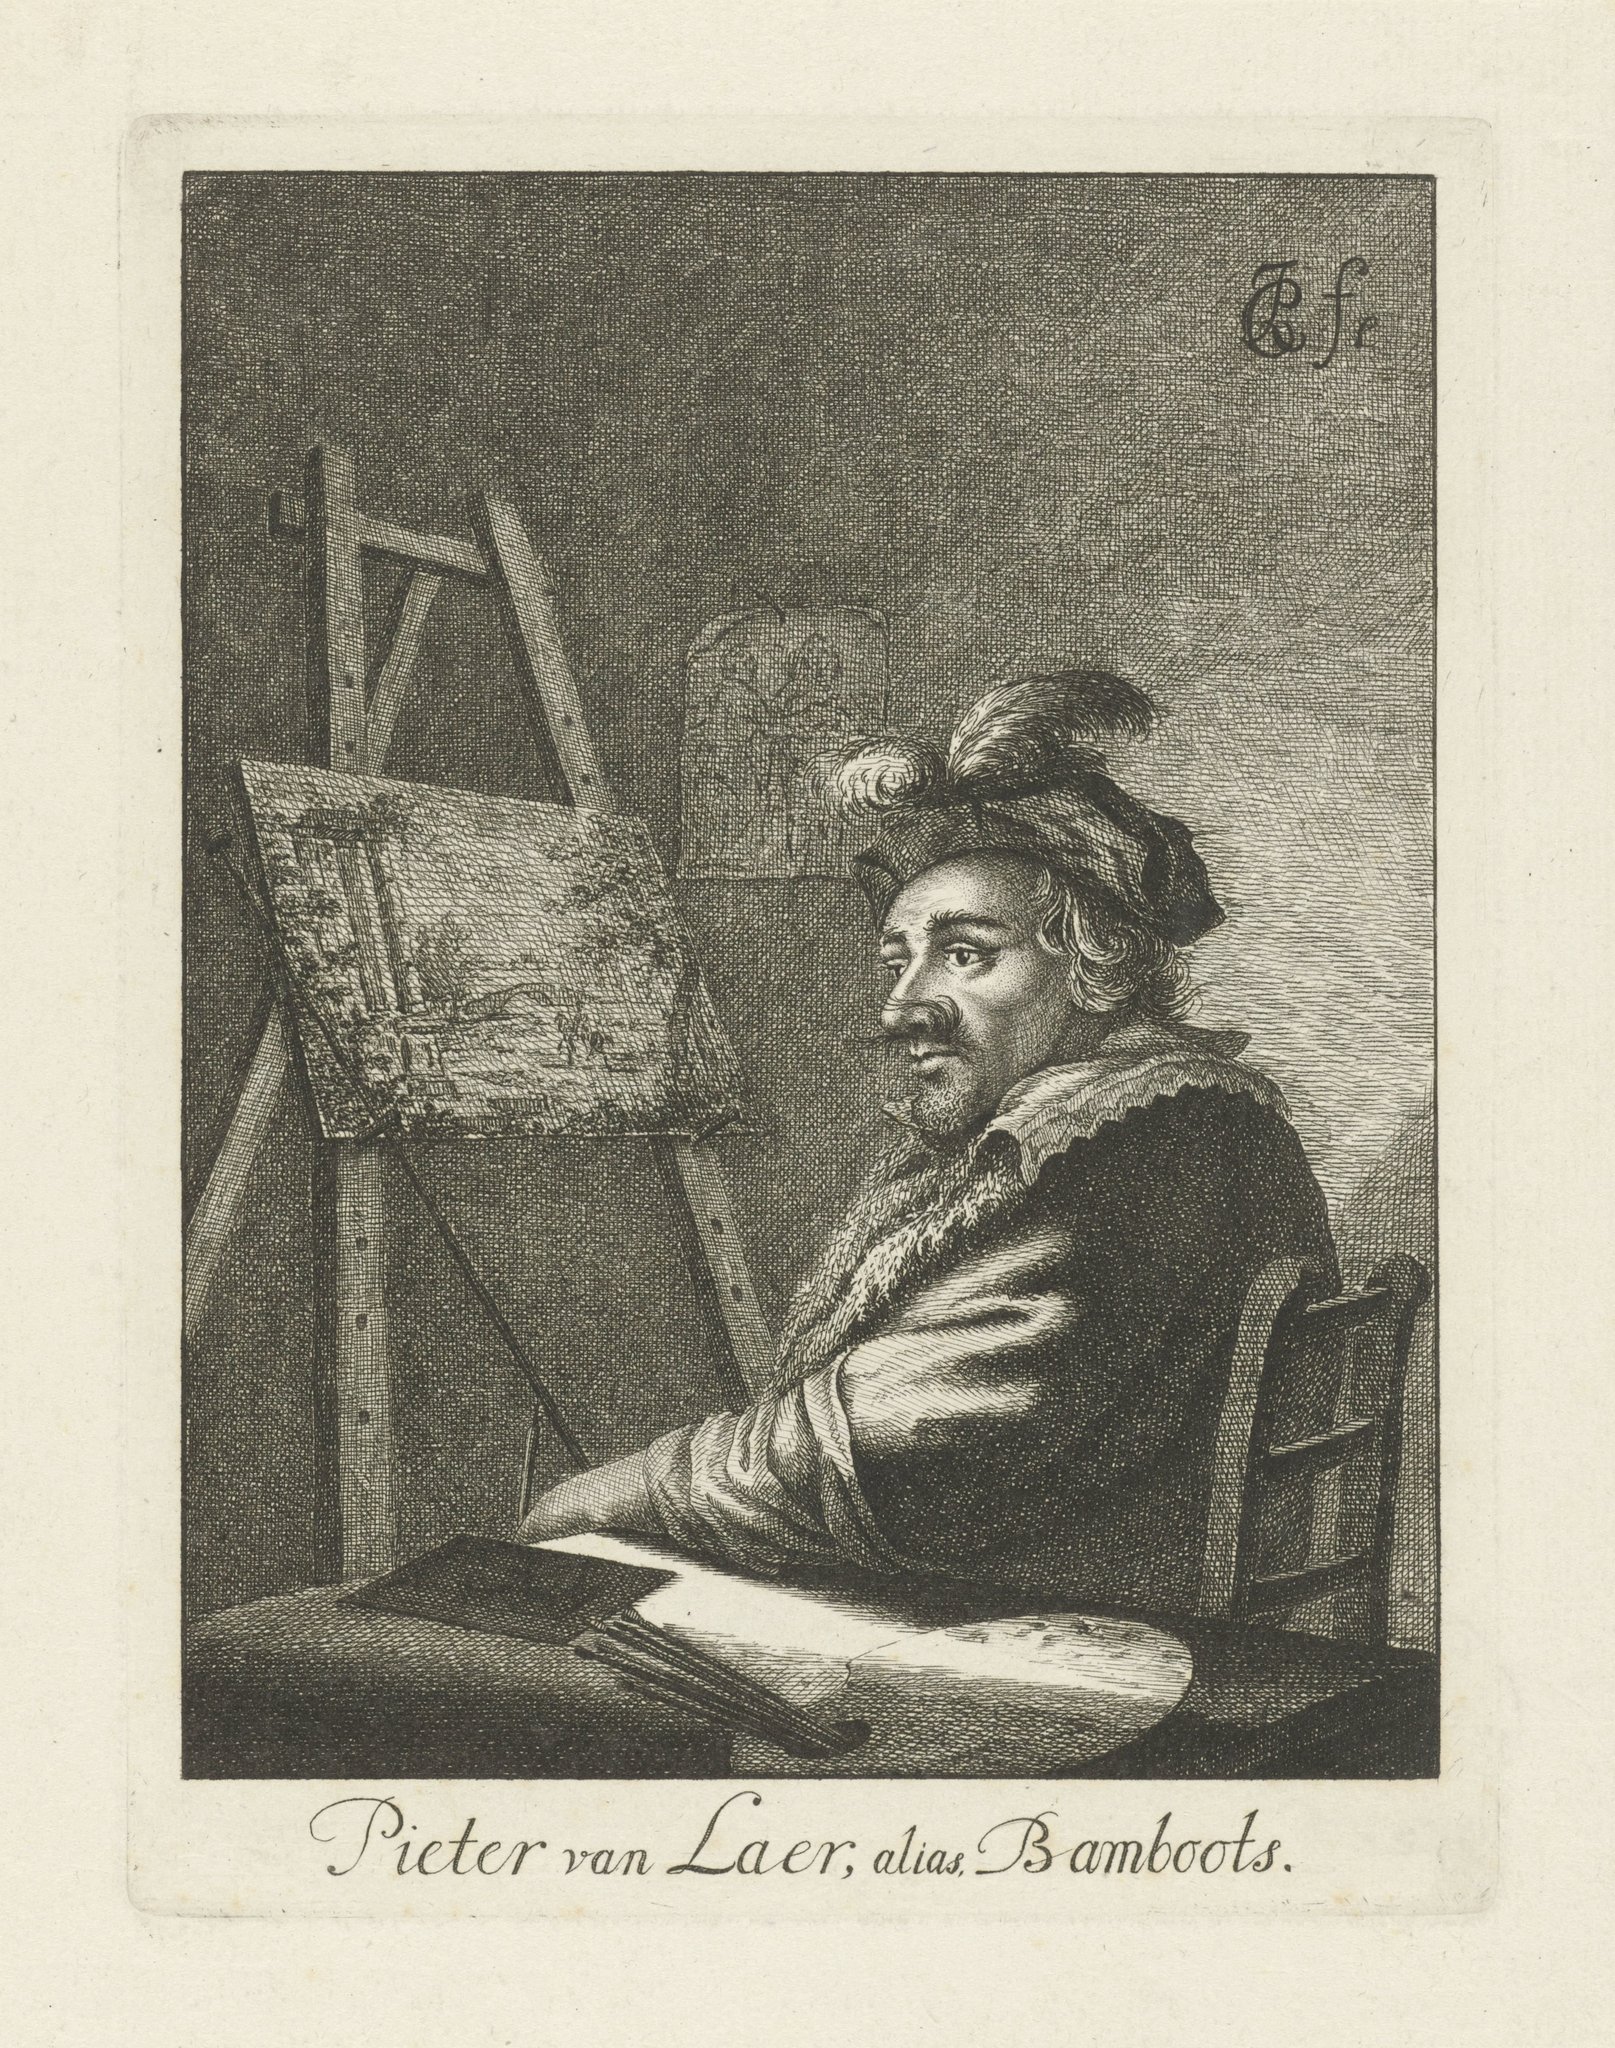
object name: print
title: Portret van Pieter Bodding van Laer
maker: caspar jacobsz. philips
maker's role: draughtsman, print maker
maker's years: 1732-1789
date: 1752-1789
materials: paper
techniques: etching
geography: amsterdam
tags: painter, print maker, draughtsman, pieter bodding van laer, portrait, self-portrait of painter, easel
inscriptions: collector's mark: Lugt 240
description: Portret van de kunstenaar Pieter Bodding van Laer, alias Bamboots, voor zijn schildersezel.